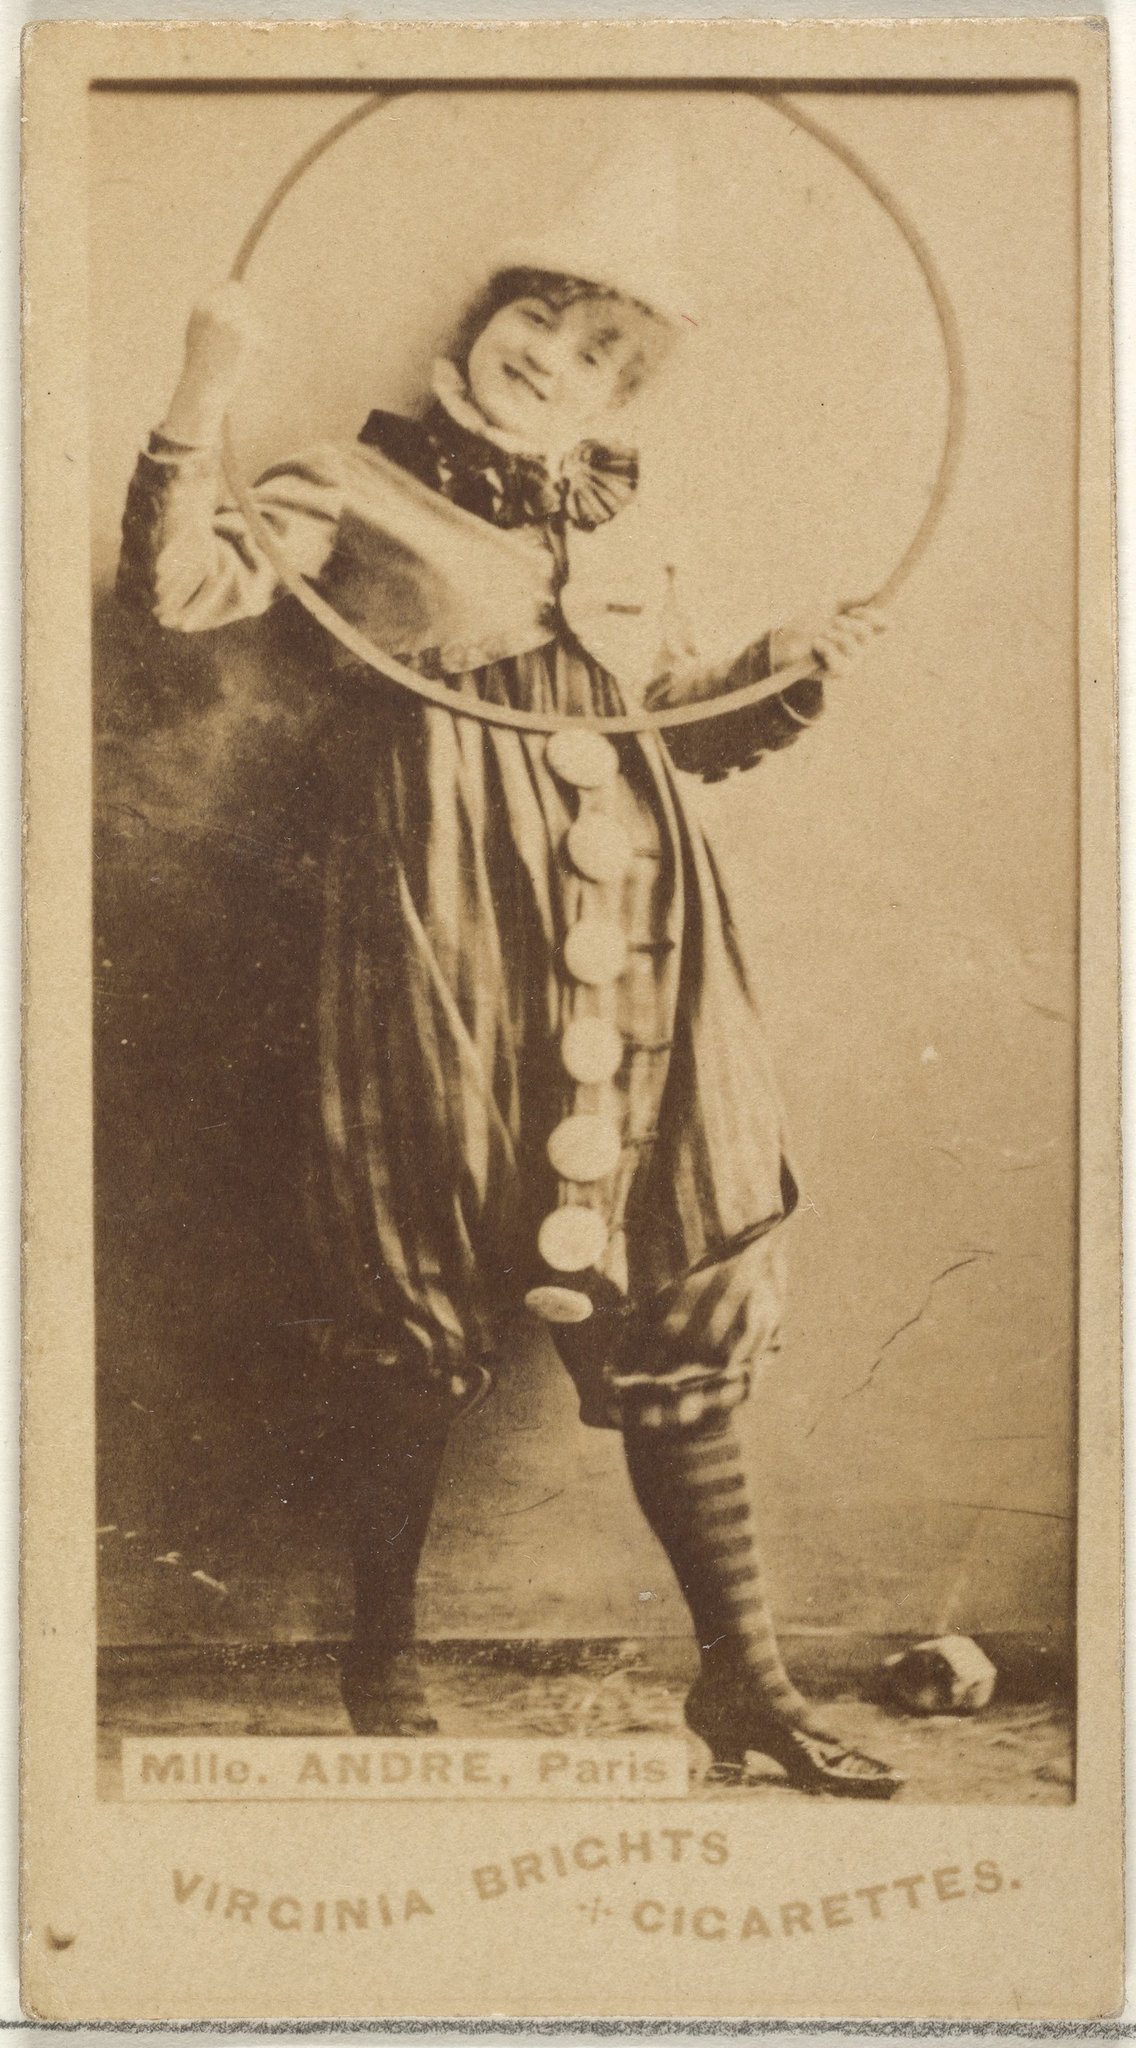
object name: photograph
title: Mlle. Andre, Paris, from the Actors and Actresses series (N45, Type 1) for Virginia Brights Cigarettes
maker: allen & ginter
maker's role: publisher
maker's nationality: american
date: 1888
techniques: albumen silver print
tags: portraits,women,actresses